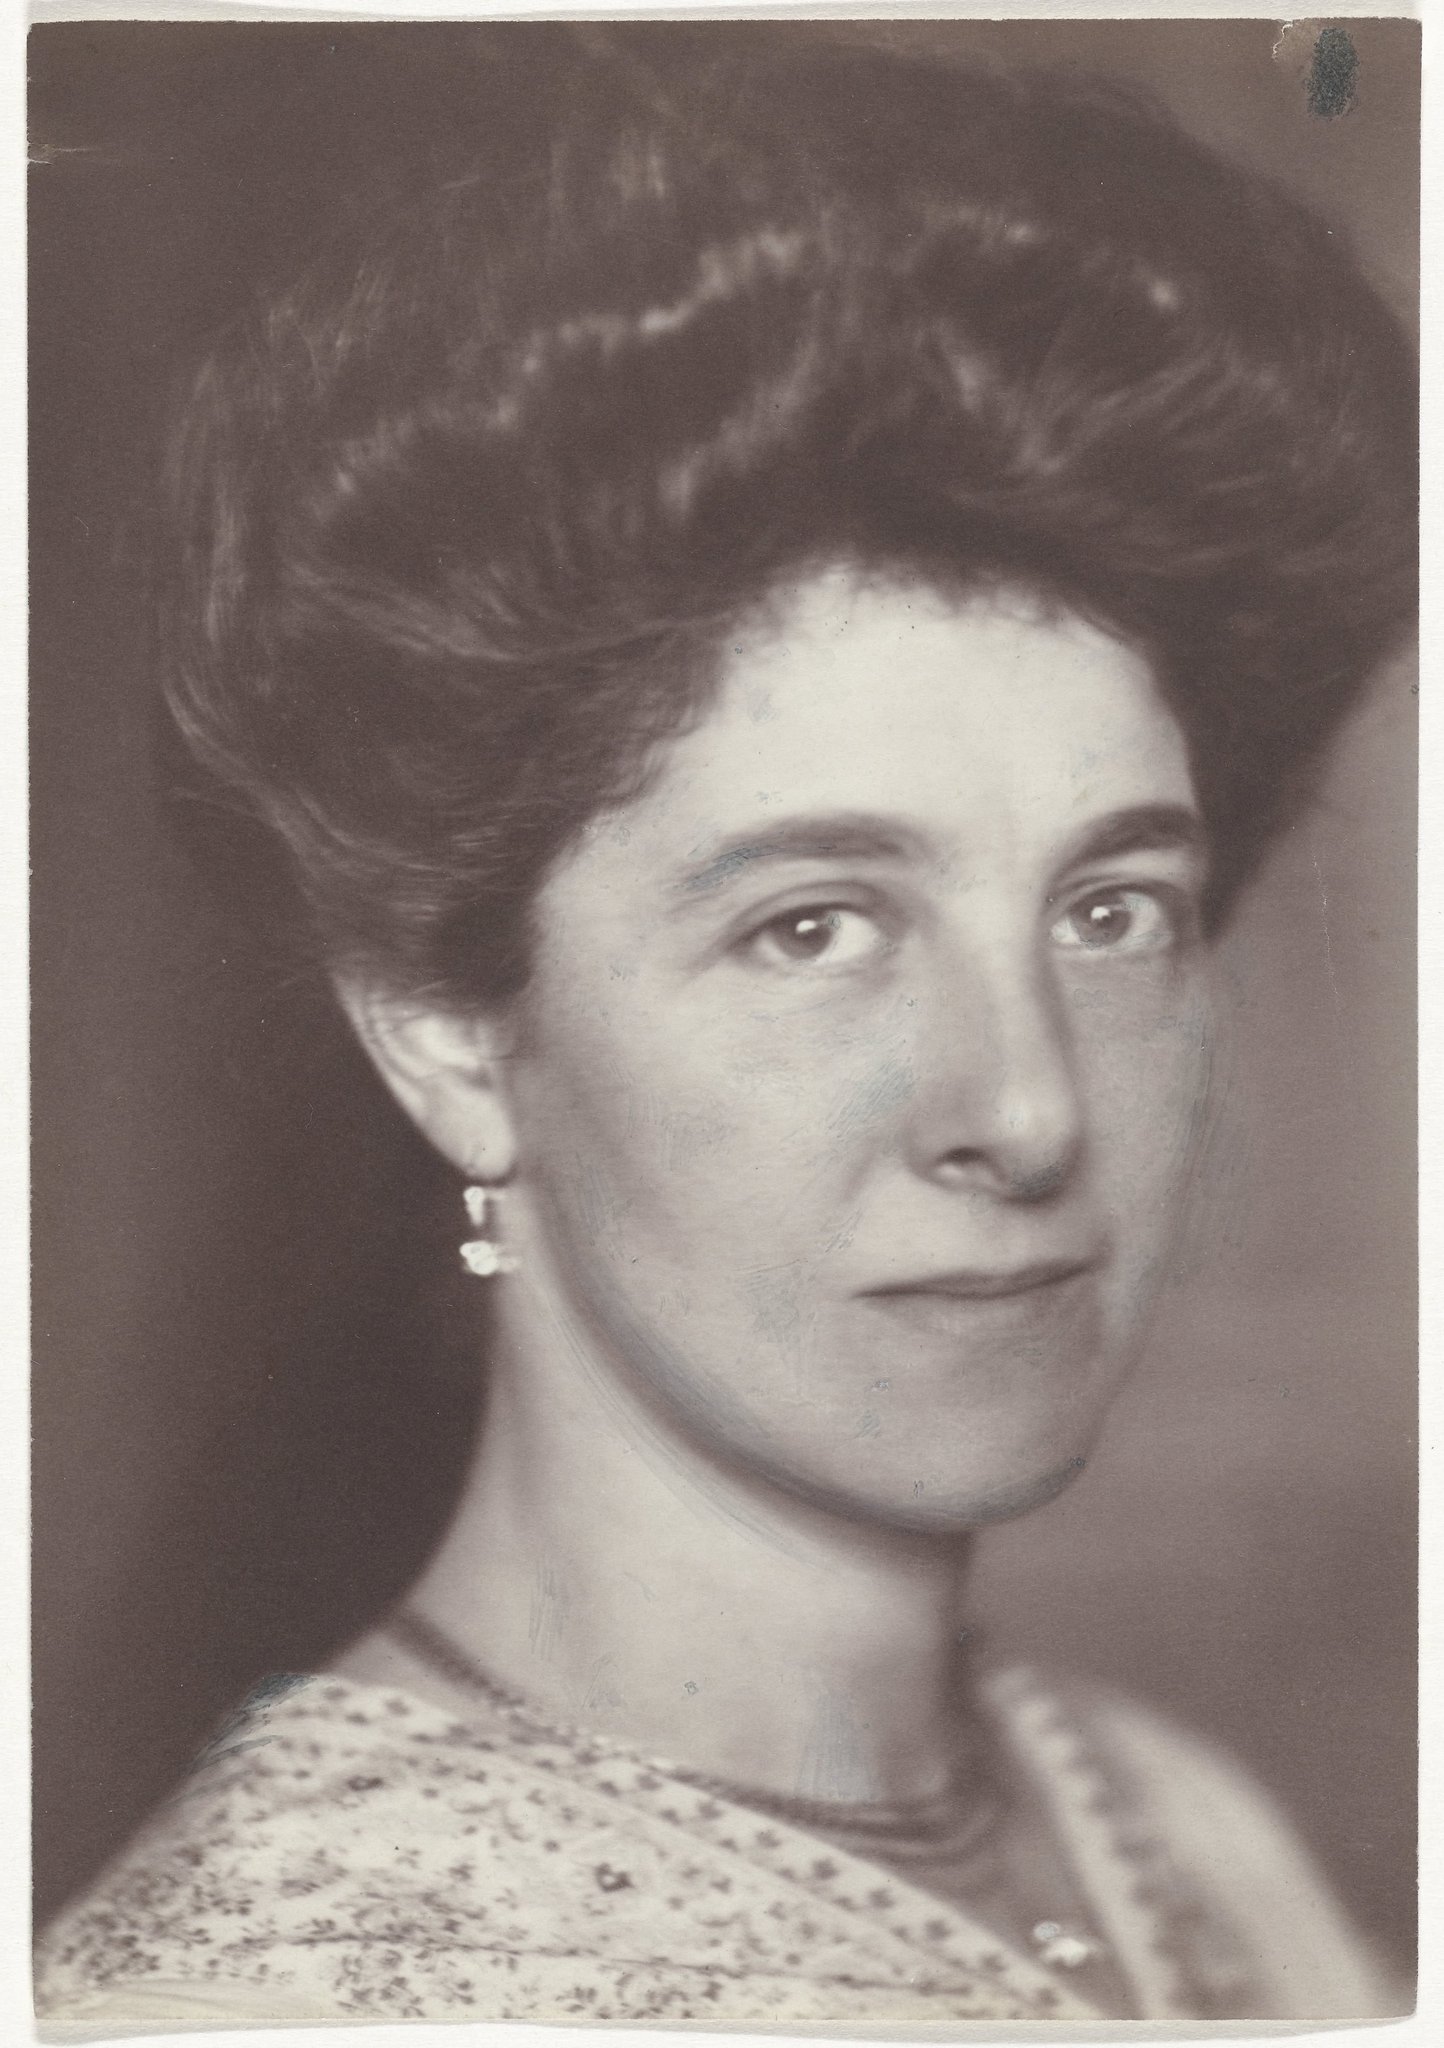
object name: photograph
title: Portret van mevrouw Sauer, de moeder van Irene With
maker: Anonymous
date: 1910-1930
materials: paper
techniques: gum bichromate, retouching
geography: germany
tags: adult woman, historical persons, germany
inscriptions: inscription: ‘moeder van Irene/ mevr. Sauer.’